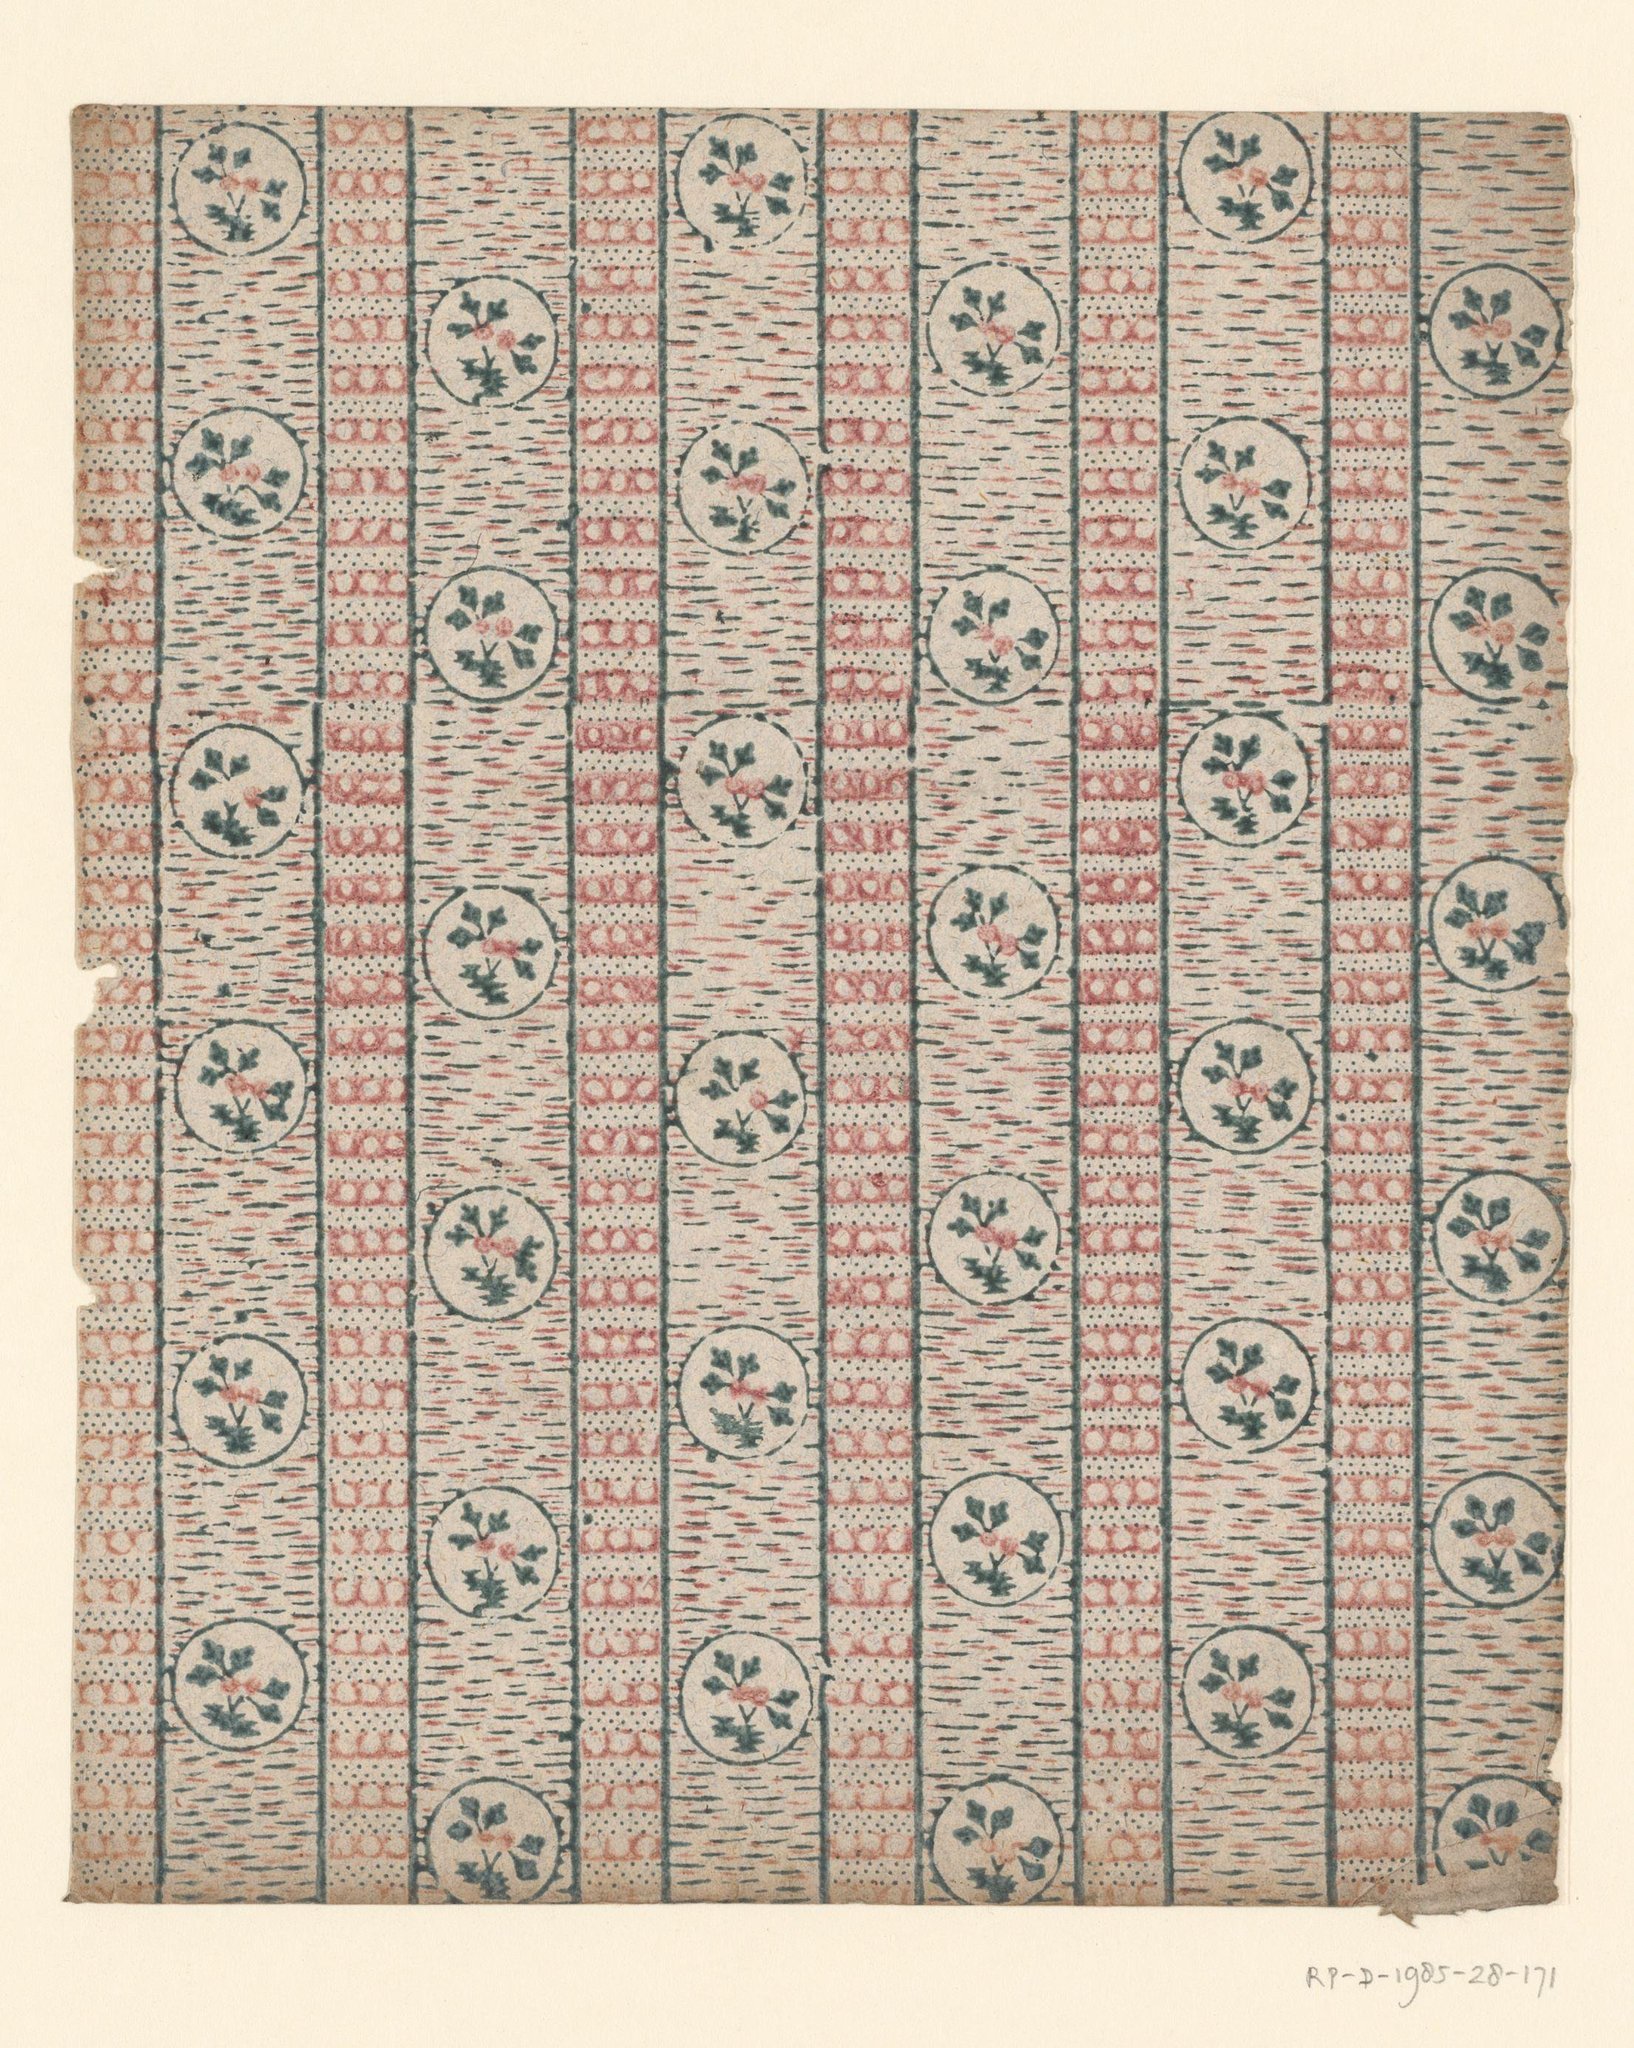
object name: printed paper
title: Blad met banenpatroon van cirkel met takje tussen sierlijst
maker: Anonymous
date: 1750-1900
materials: paper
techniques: printing block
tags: ornament derived from plant forms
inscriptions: collector's mark: Lugt 2760, collector's mark: Lugt 2228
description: Blad met banenpatroon van cirkel met takje tussen sierlijsten. Helft van een omslag.